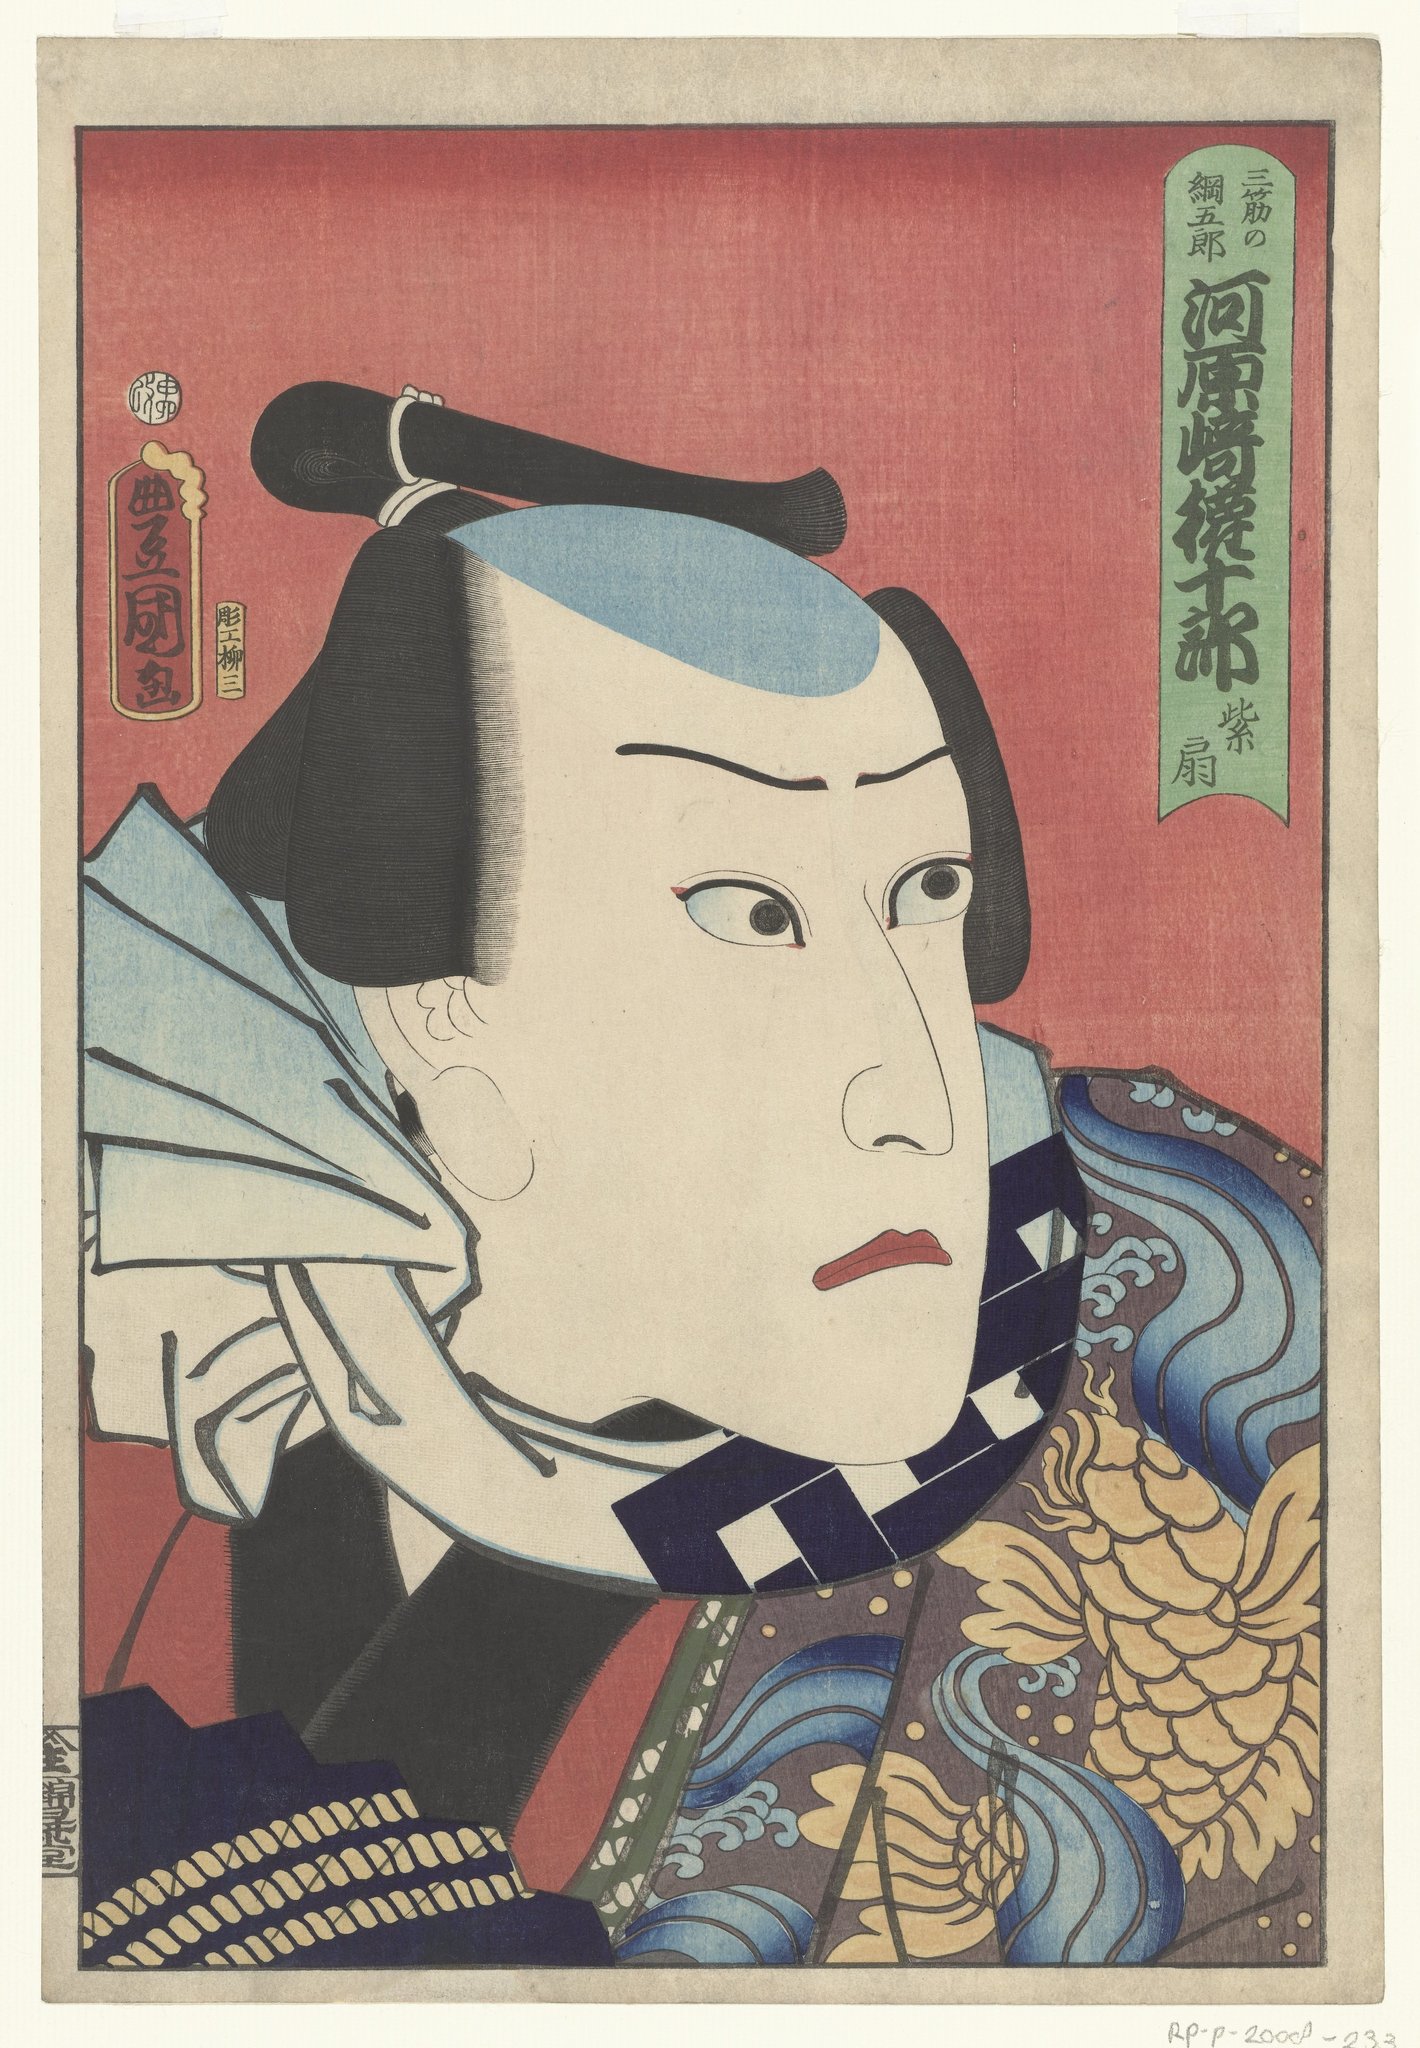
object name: print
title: Kawarazaki Gonjuro I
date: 1804-1860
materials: paper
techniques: woodcut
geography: tokyo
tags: portrait of actor, actress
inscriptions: date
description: Buste portret van de acteur Kawarazaki Gonjuro I in de rol van Sansuke Kogoro; tegen rode achtergrond.